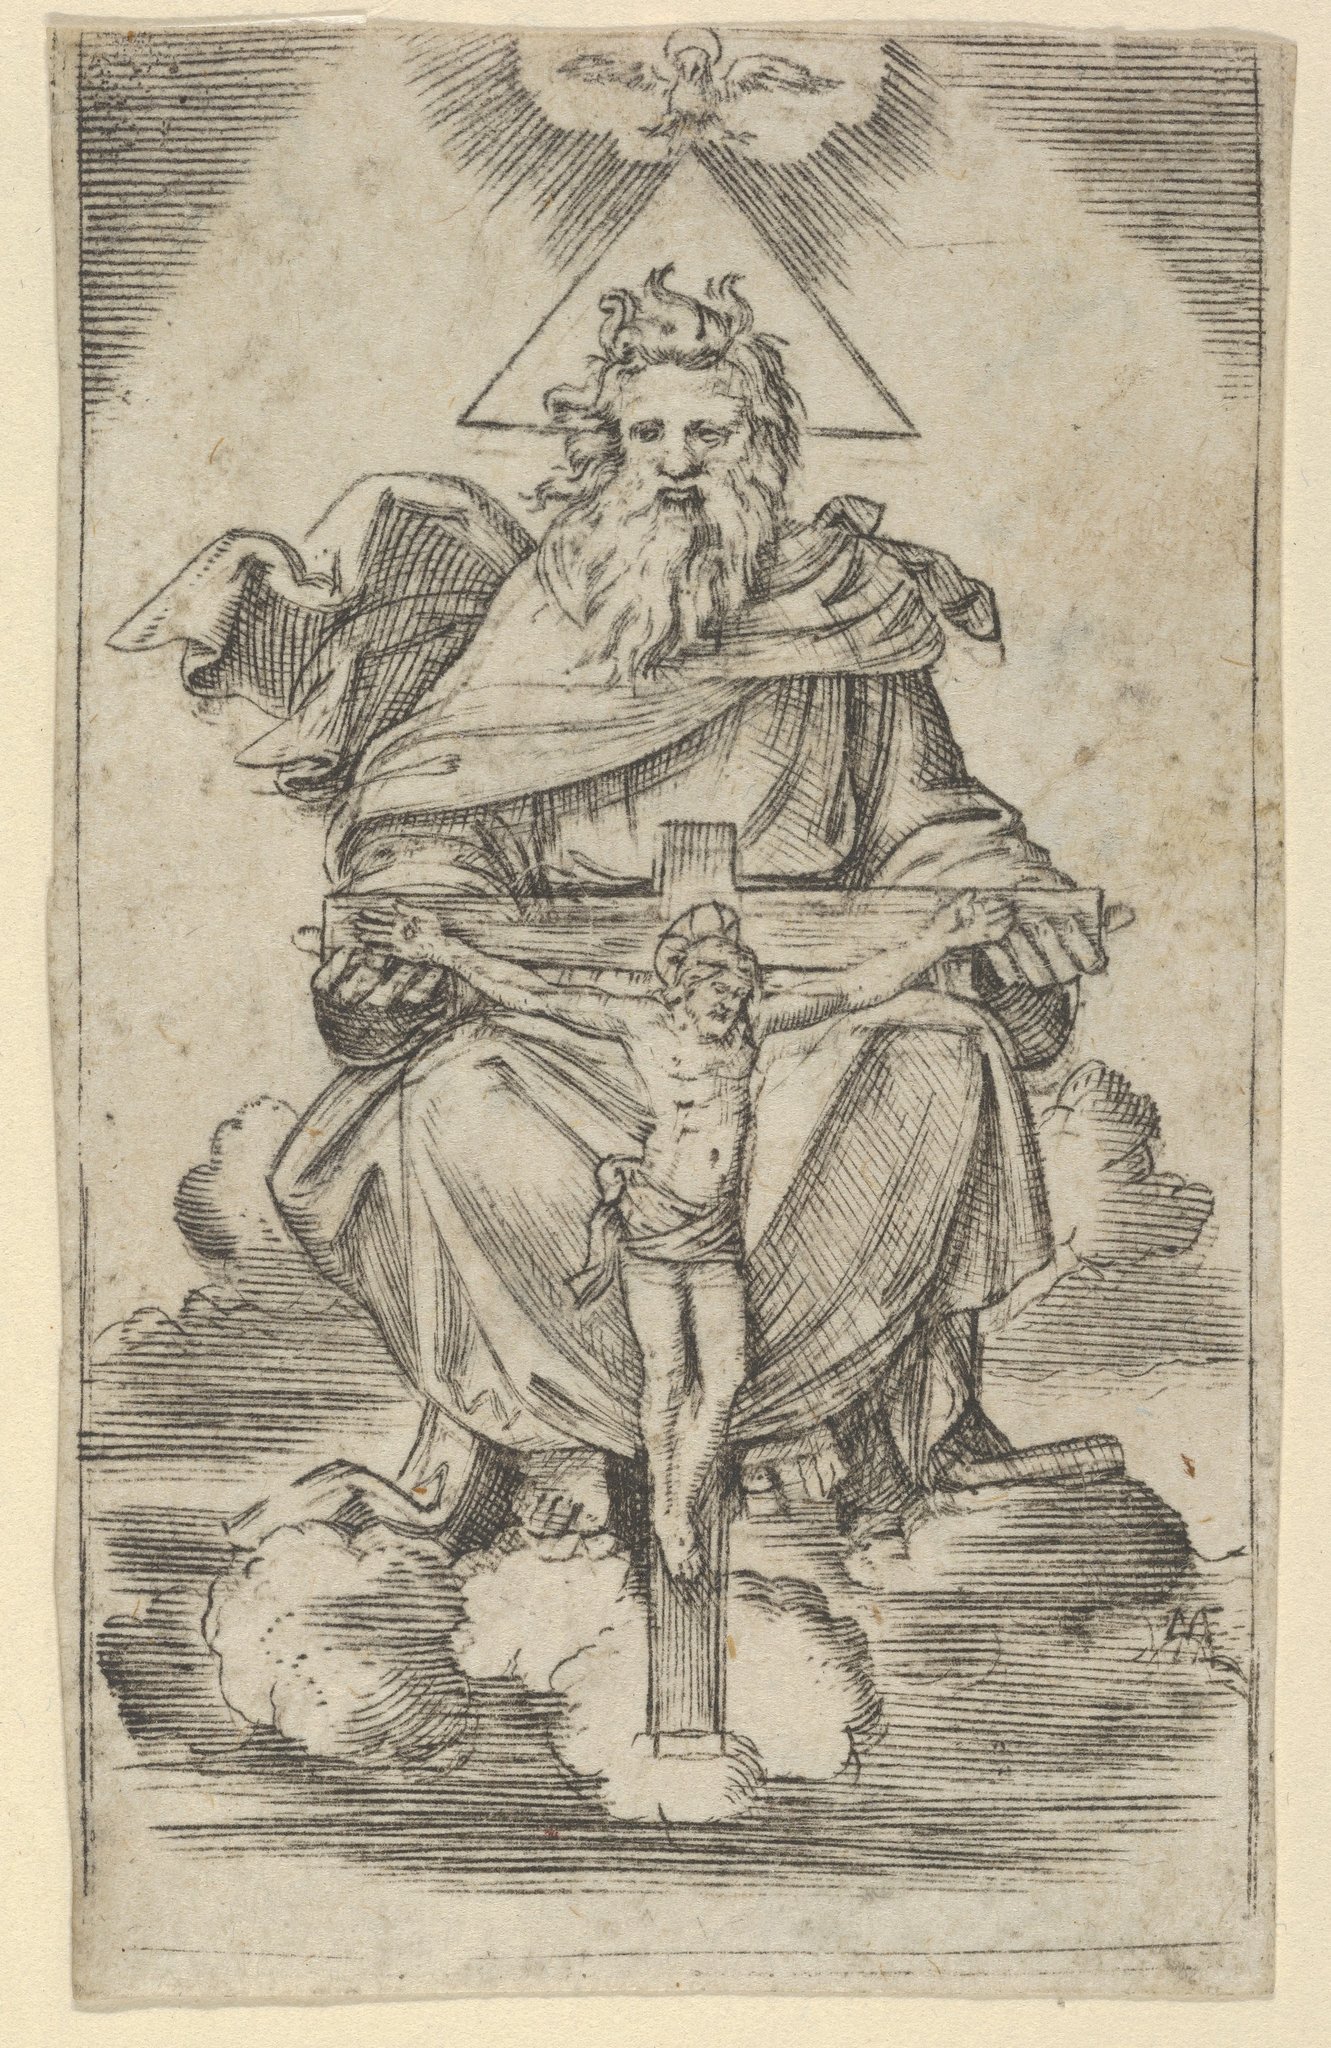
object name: print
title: The Holy Trinity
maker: marcantonio raimondi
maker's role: artist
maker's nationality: italian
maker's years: 1475-1534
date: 1500-1527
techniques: engraving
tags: christ,crucifixion,god the father